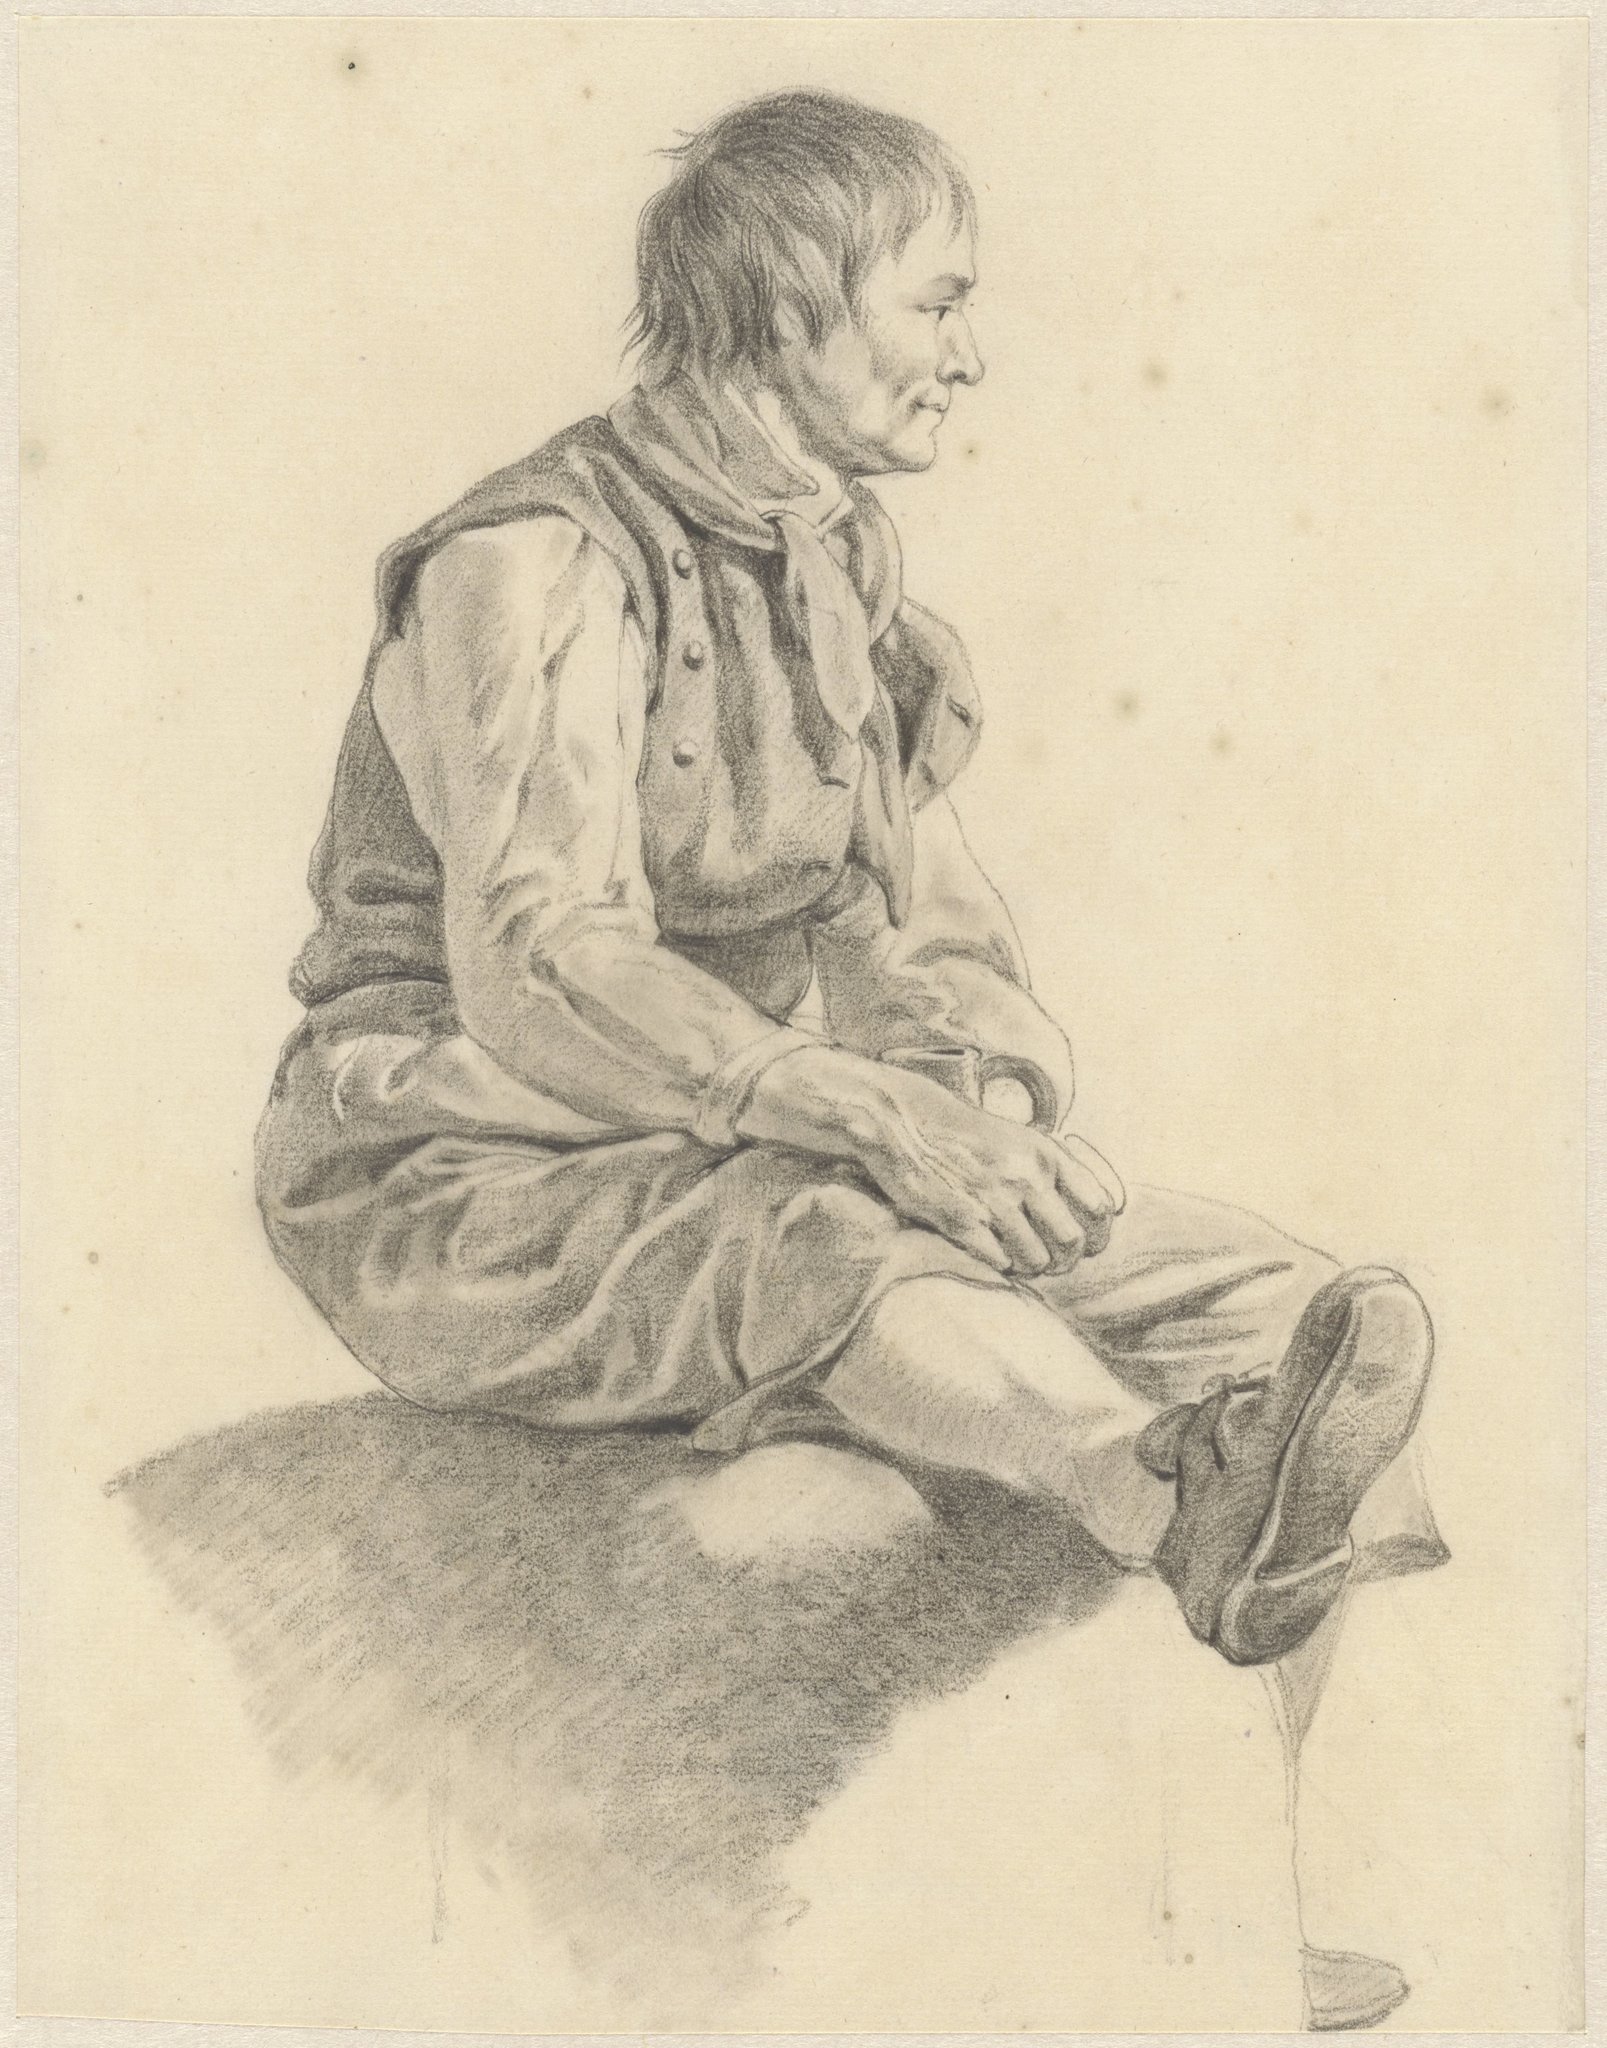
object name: drawing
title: Zittende man, en profil naar rechts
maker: adrianus van der koogh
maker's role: draughtsman, print maker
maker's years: 1796-1831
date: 1806-1831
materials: chalk, paper